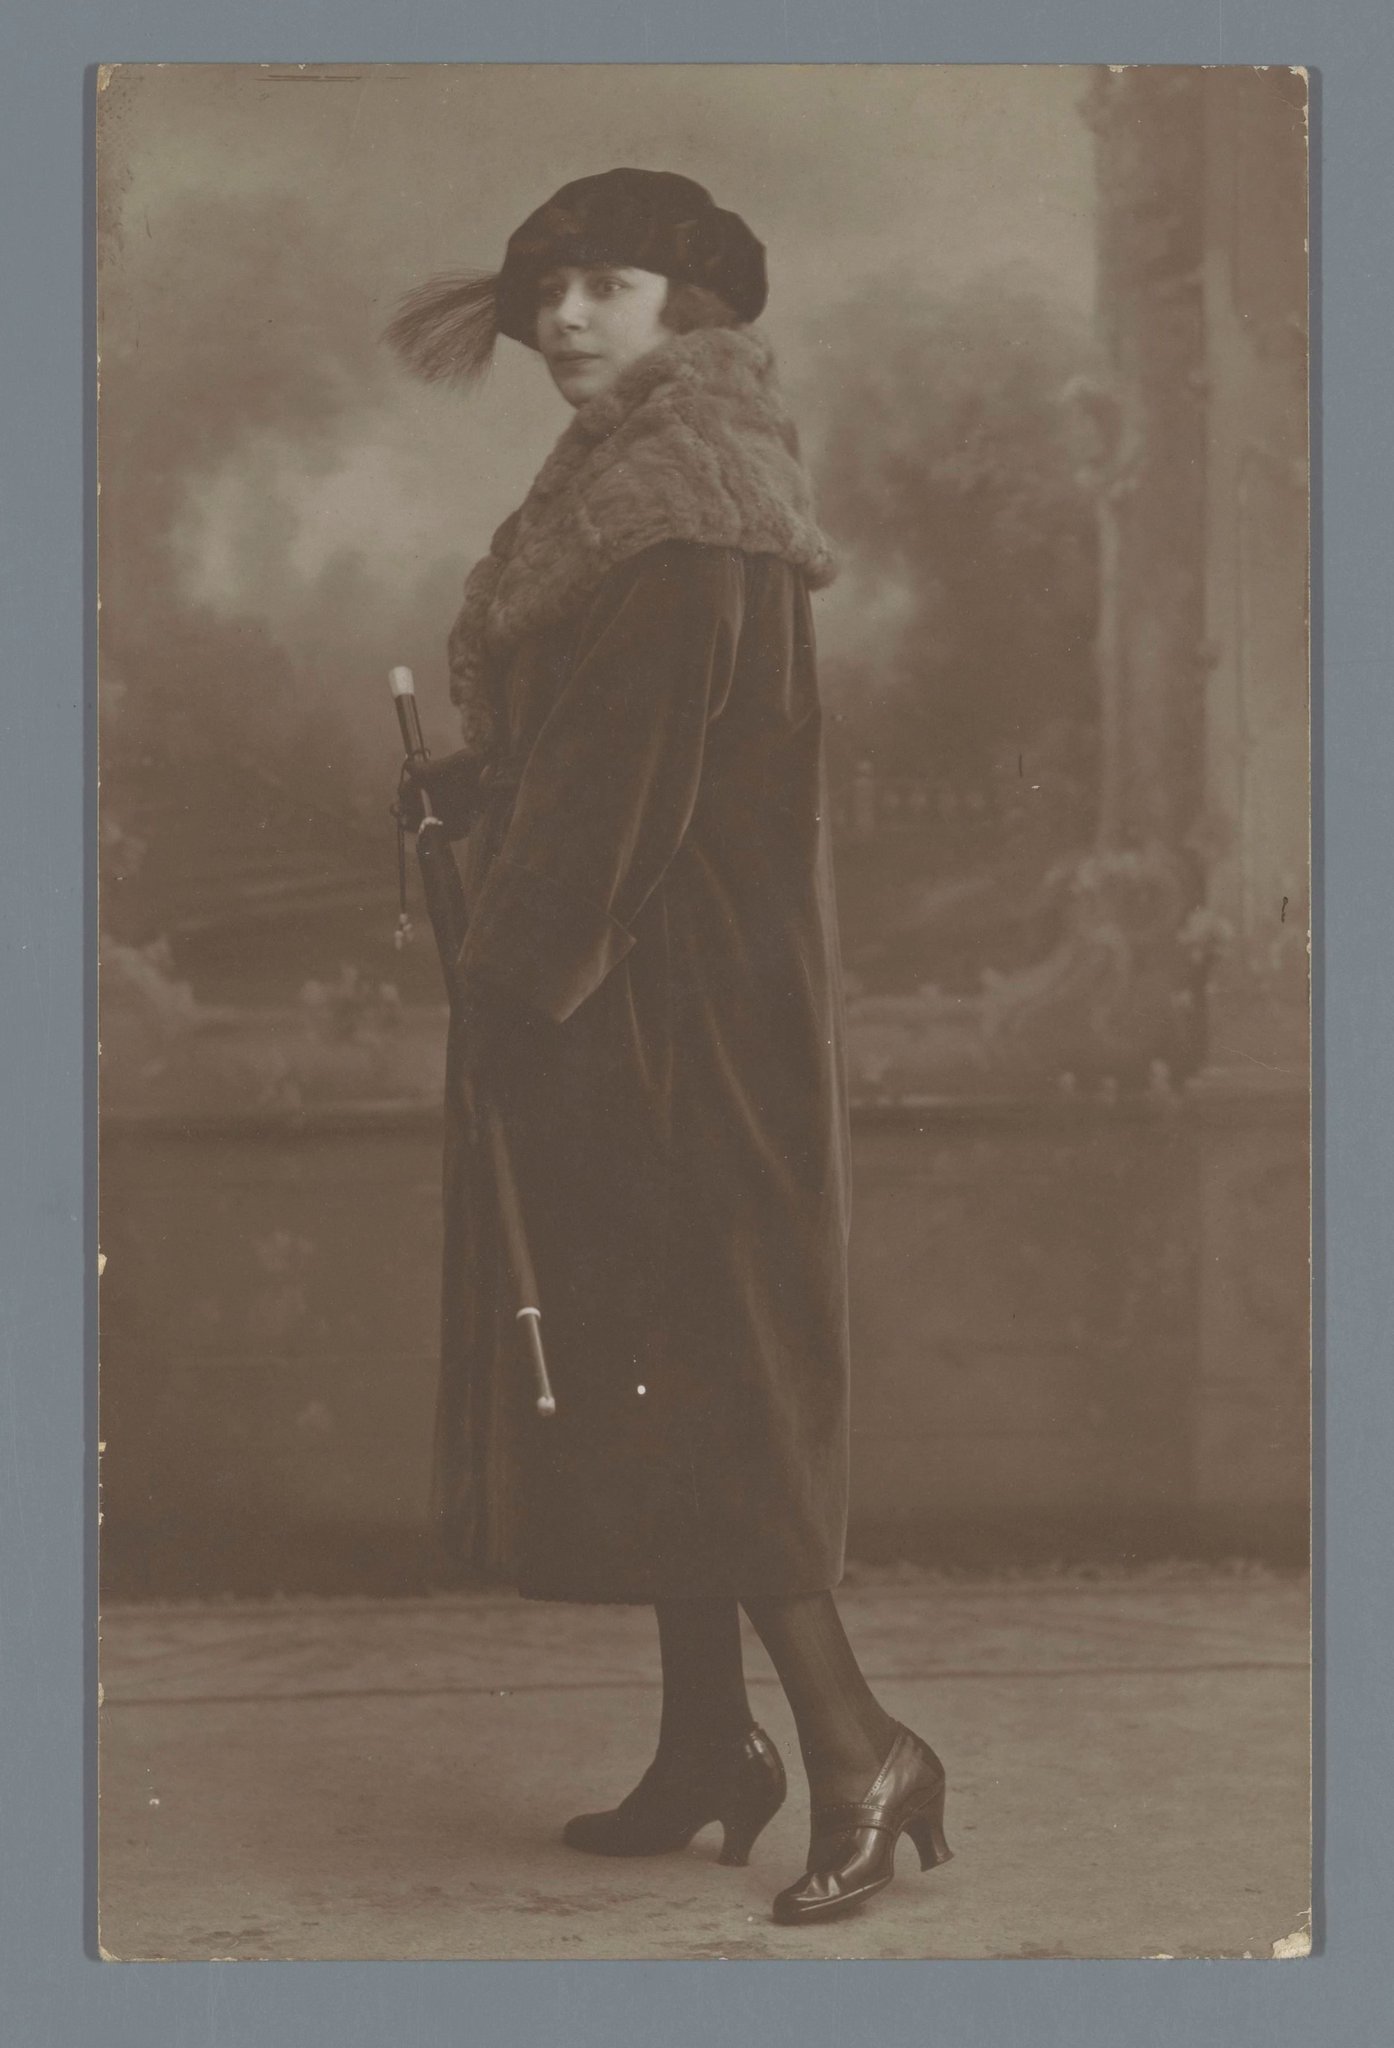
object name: photograph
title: Studioportret van een onbekende vrouw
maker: Anonymous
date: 1907-1920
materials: photographic support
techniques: gelatin silver print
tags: studio ~ photographer, adult woman